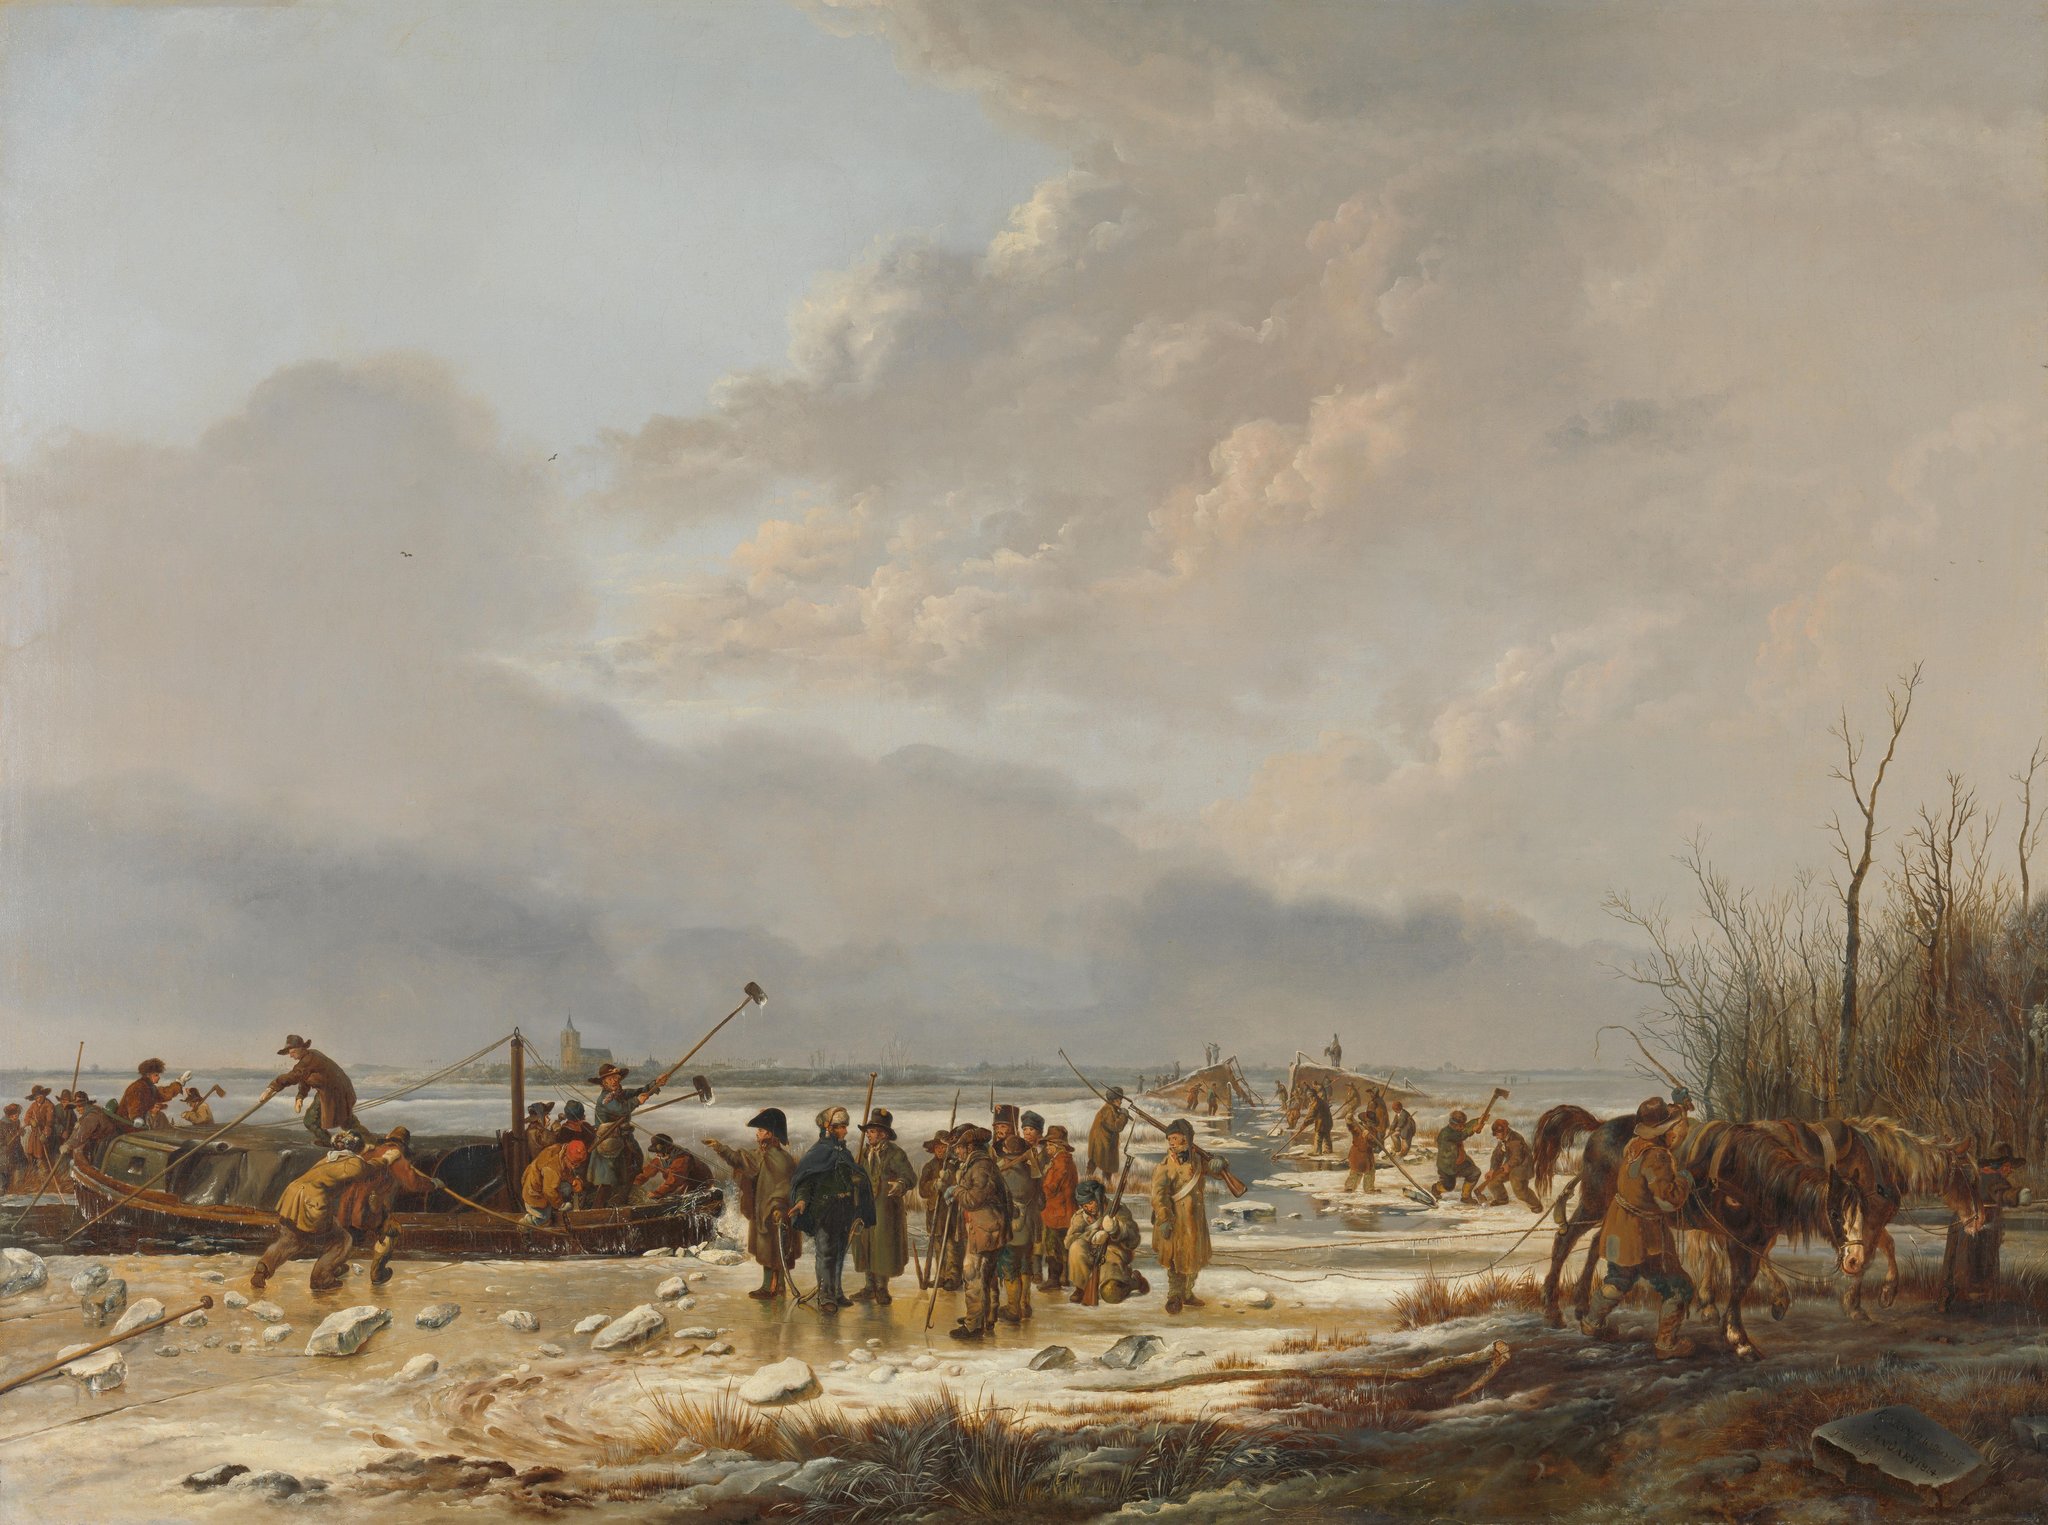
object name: painting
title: Breaking the Ice on the Karnemelksloot, Naarden, January 1814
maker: pieter gerardus van os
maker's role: draughtsman, painter, print maker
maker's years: 1776-1839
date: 1814-1815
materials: canvas, oil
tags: siege, position war, tow-boat, towing-barge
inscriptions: signature, date and inscription: ‘Karnemelksloot January 1814 PG van Os fecit.’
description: Breaking the ice on Karnemelksloot at Naarden, 1814, by P.G. van Os. Not all of Napoleon's troops retreated after the collapse of French rule in 1813. Well-armed and with plenty of provisions, the remainder were able to hold their positions in a number of garrison towns. At Den Helder, Naarden, Grave and Delfzijl they eventually capitulated in the spring of 1814 when the new king of France ordered that French troops should evacuate all fortifications outside the country's borders. The Naarden waterway, Karnemelksloot, had frozen over in early January. To prevent a French attack across the ice, it was broken open with a local ferry barge.